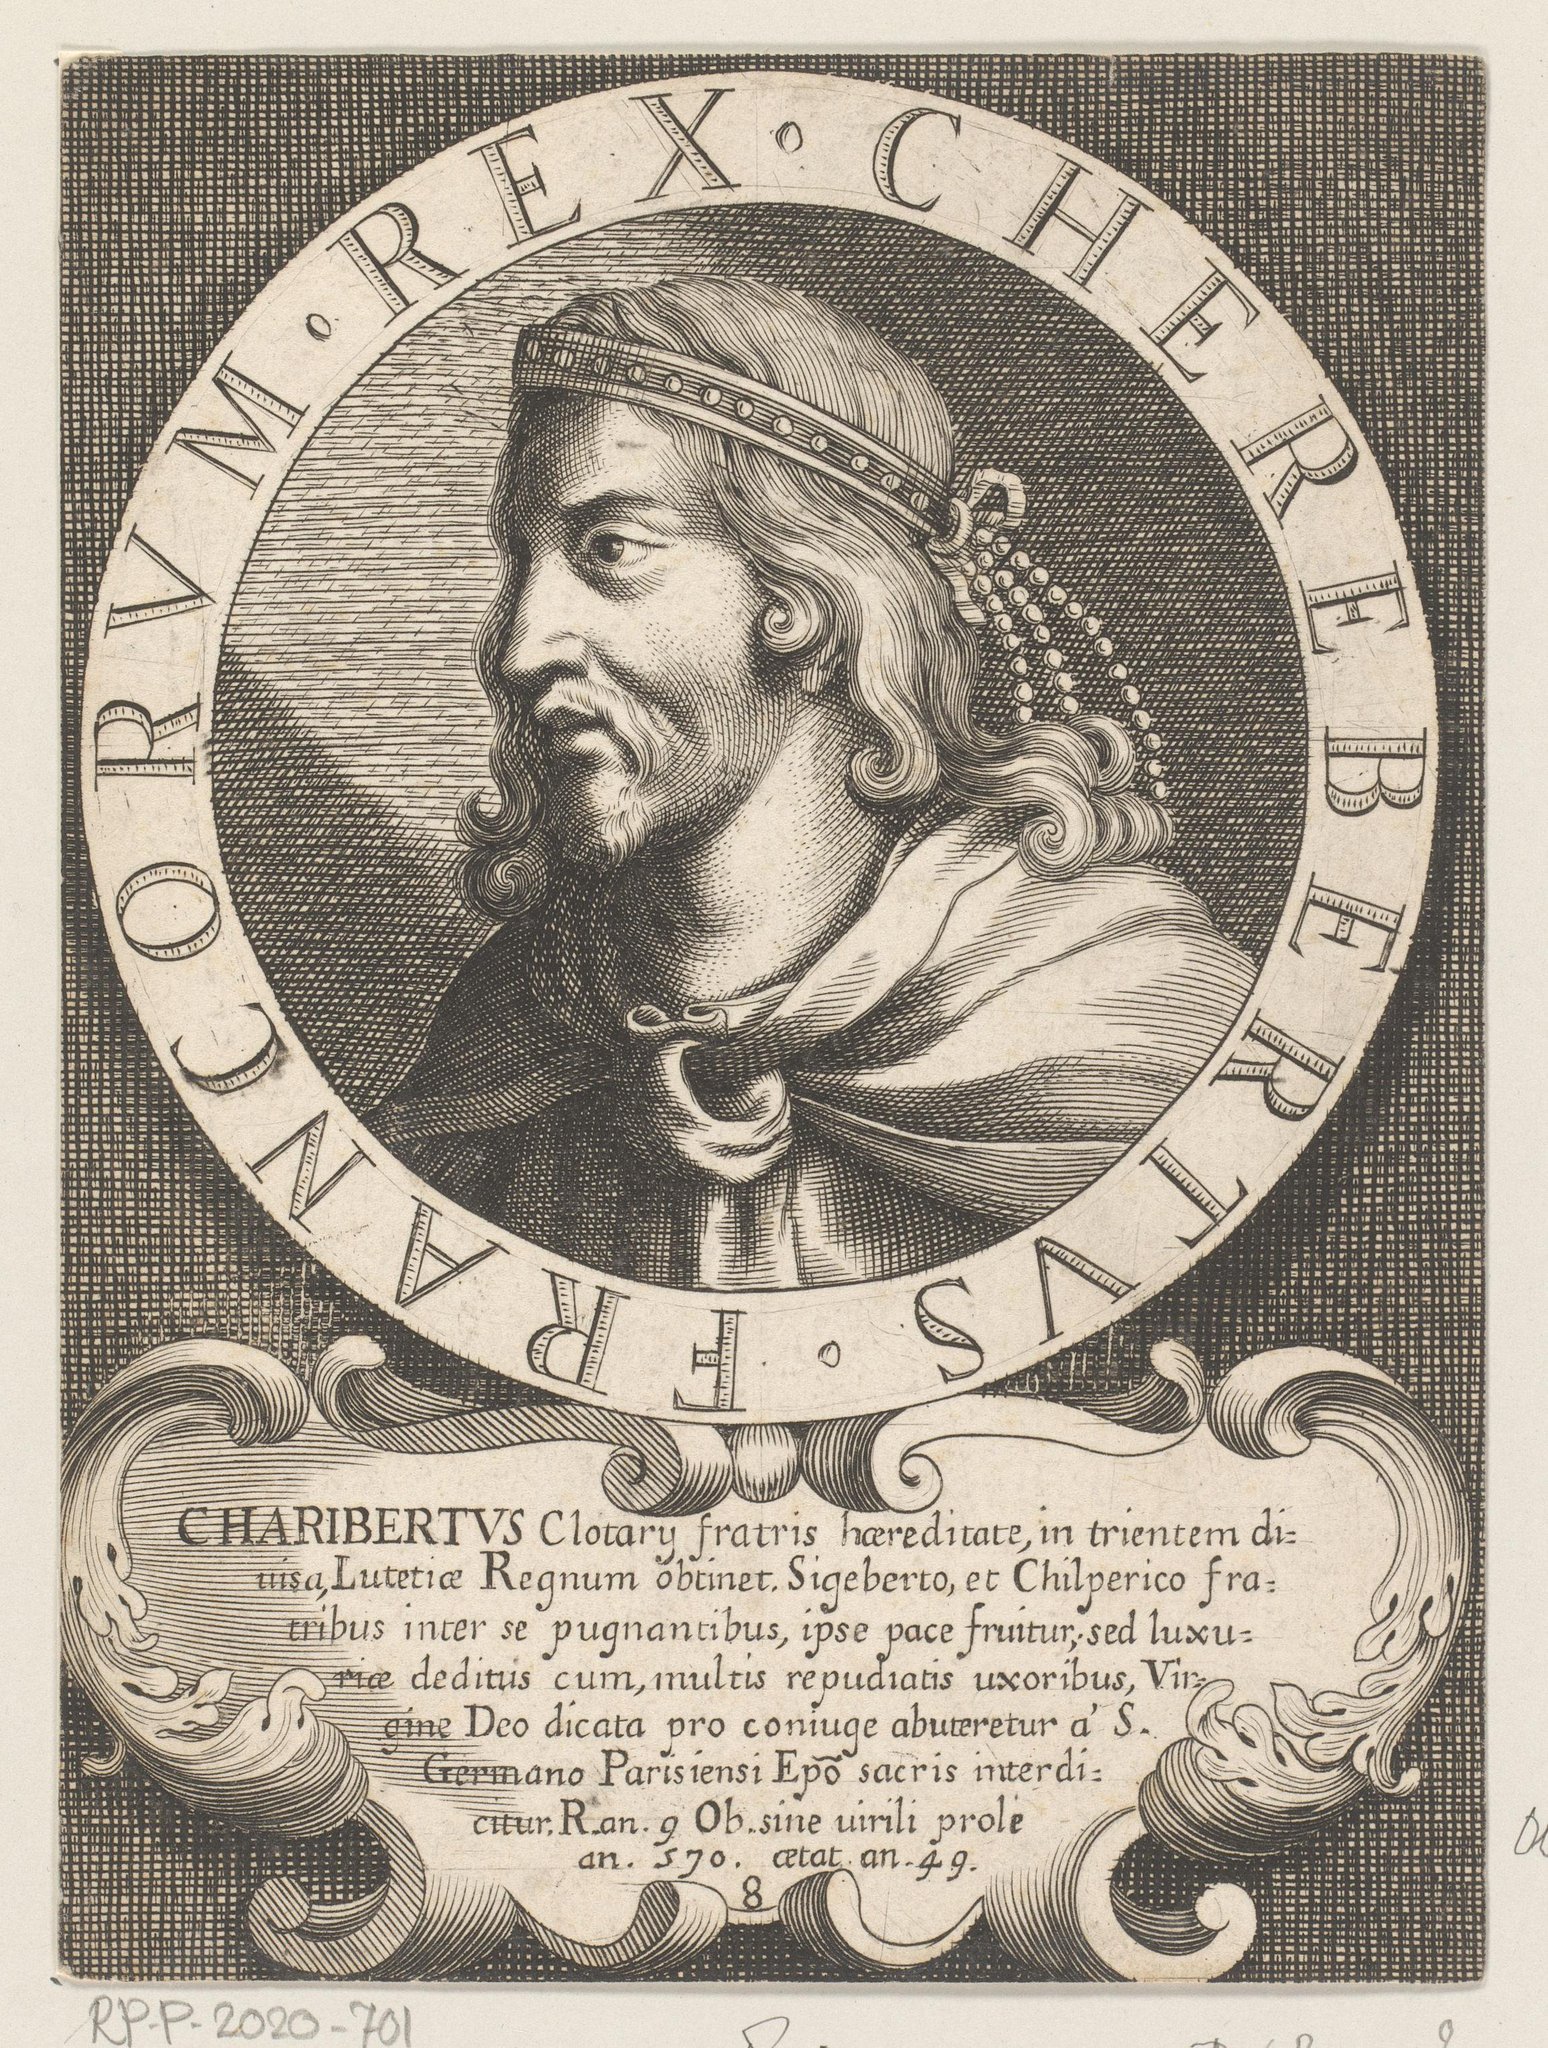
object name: print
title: Cherebertus Francorum Rex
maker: Anonymous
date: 1630-1699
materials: paper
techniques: engraving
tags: historical persons, ruler, sovereign